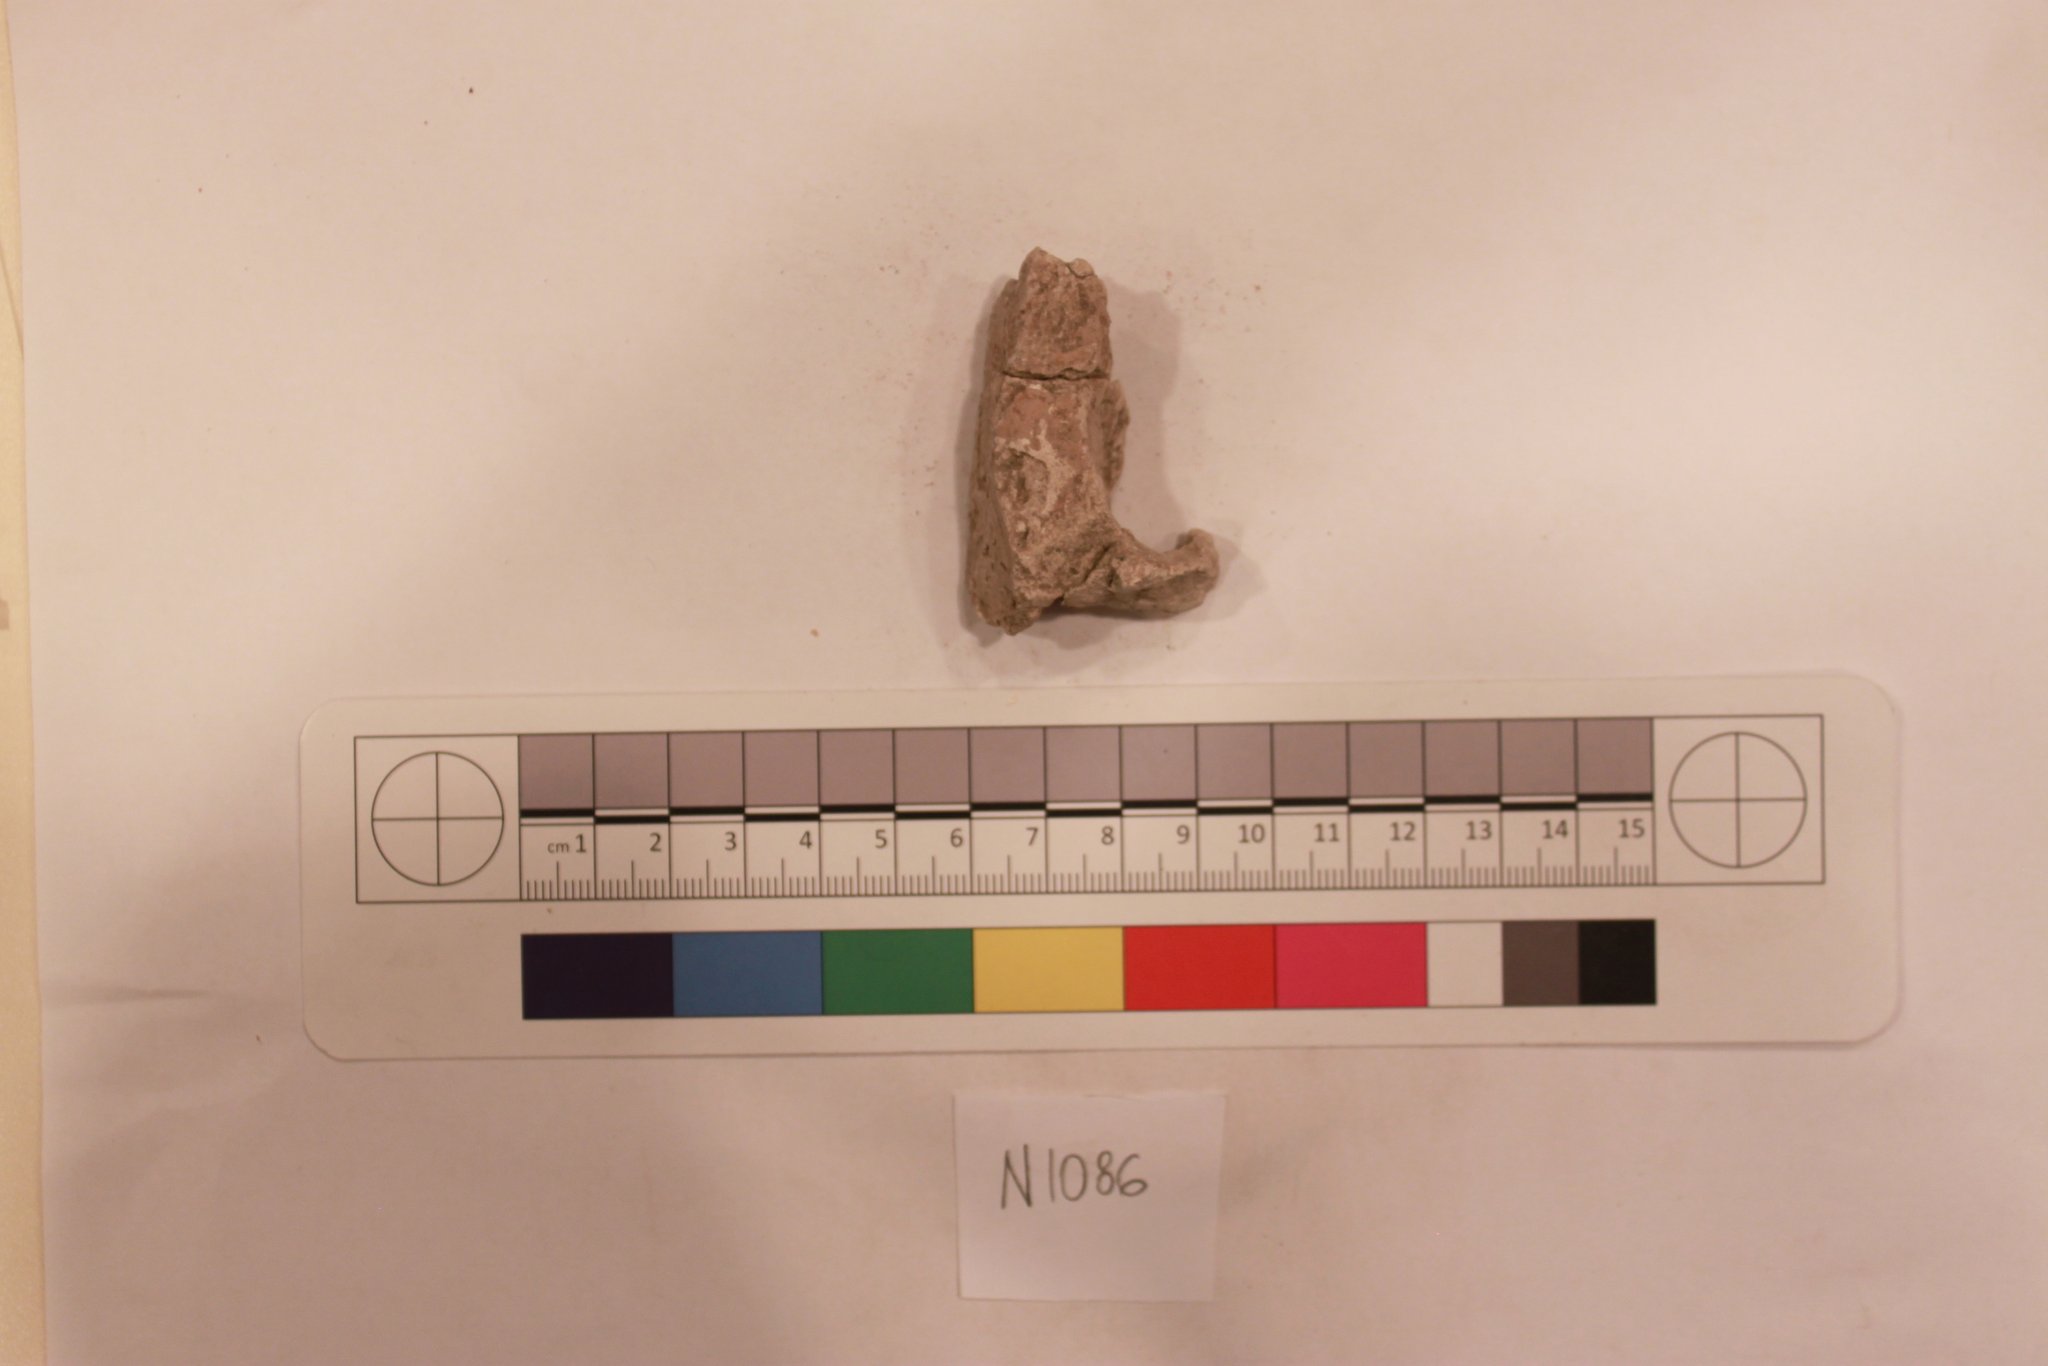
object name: fragment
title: Stucco Fragment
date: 701-1200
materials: plaster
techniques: carving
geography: iran